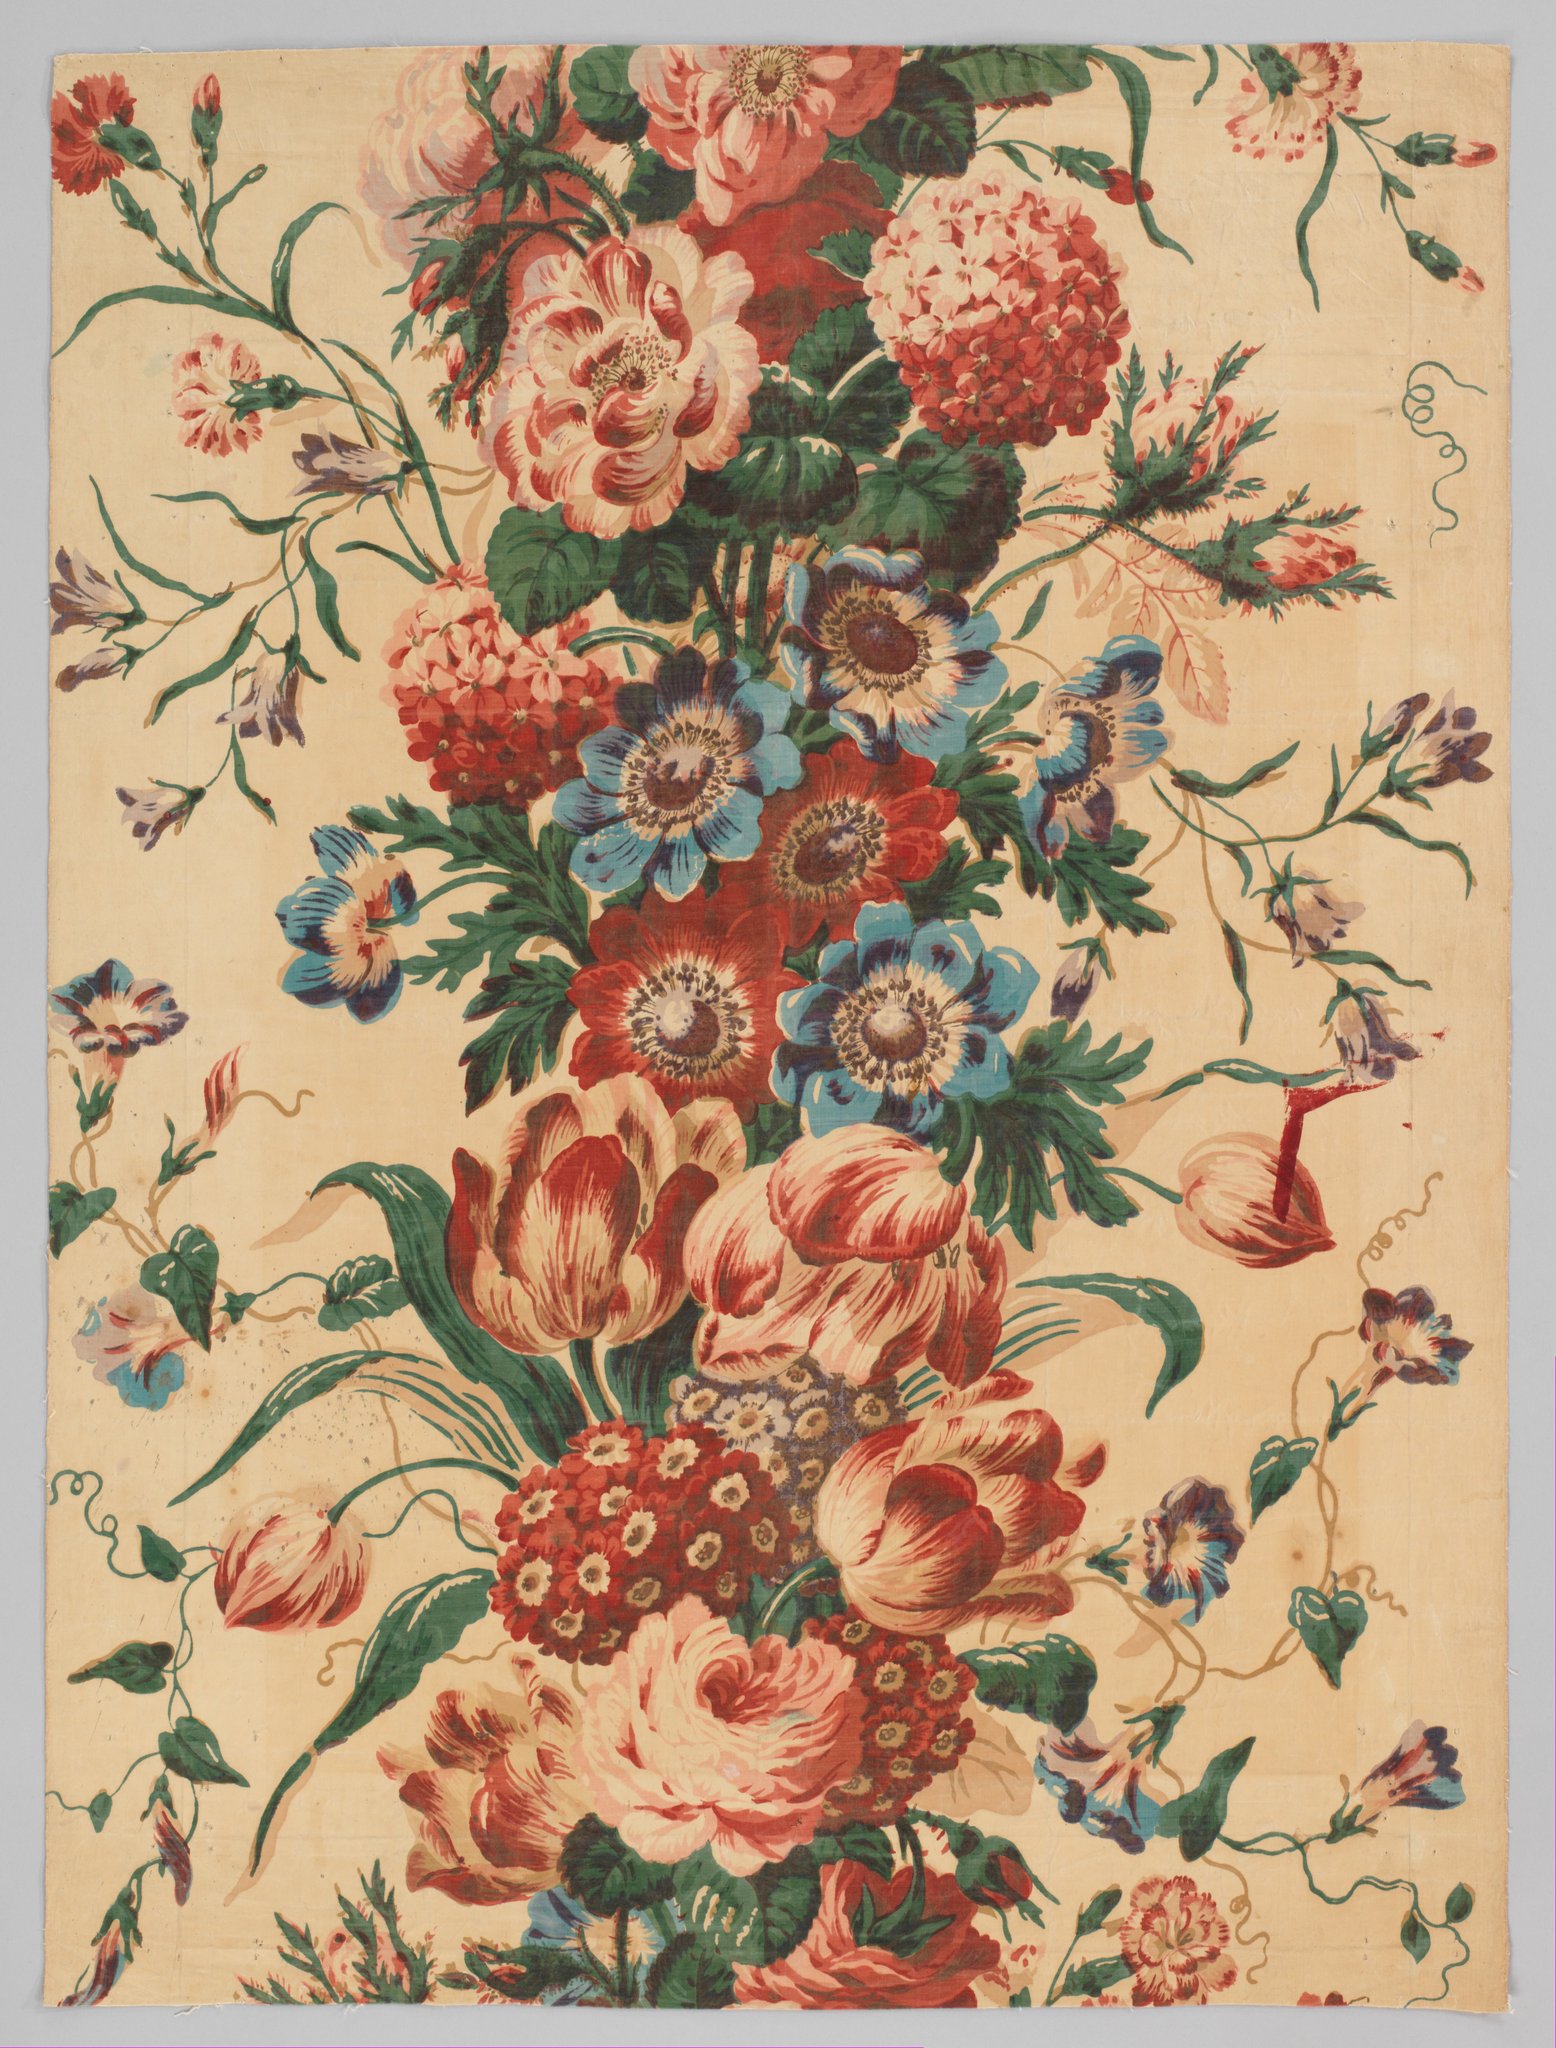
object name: piece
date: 1851-1872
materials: cotton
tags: flowers